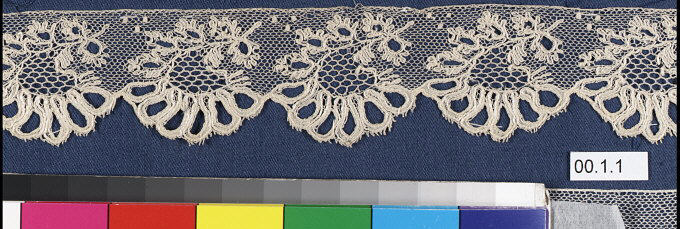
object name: fragment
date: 1801-1900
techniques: lace